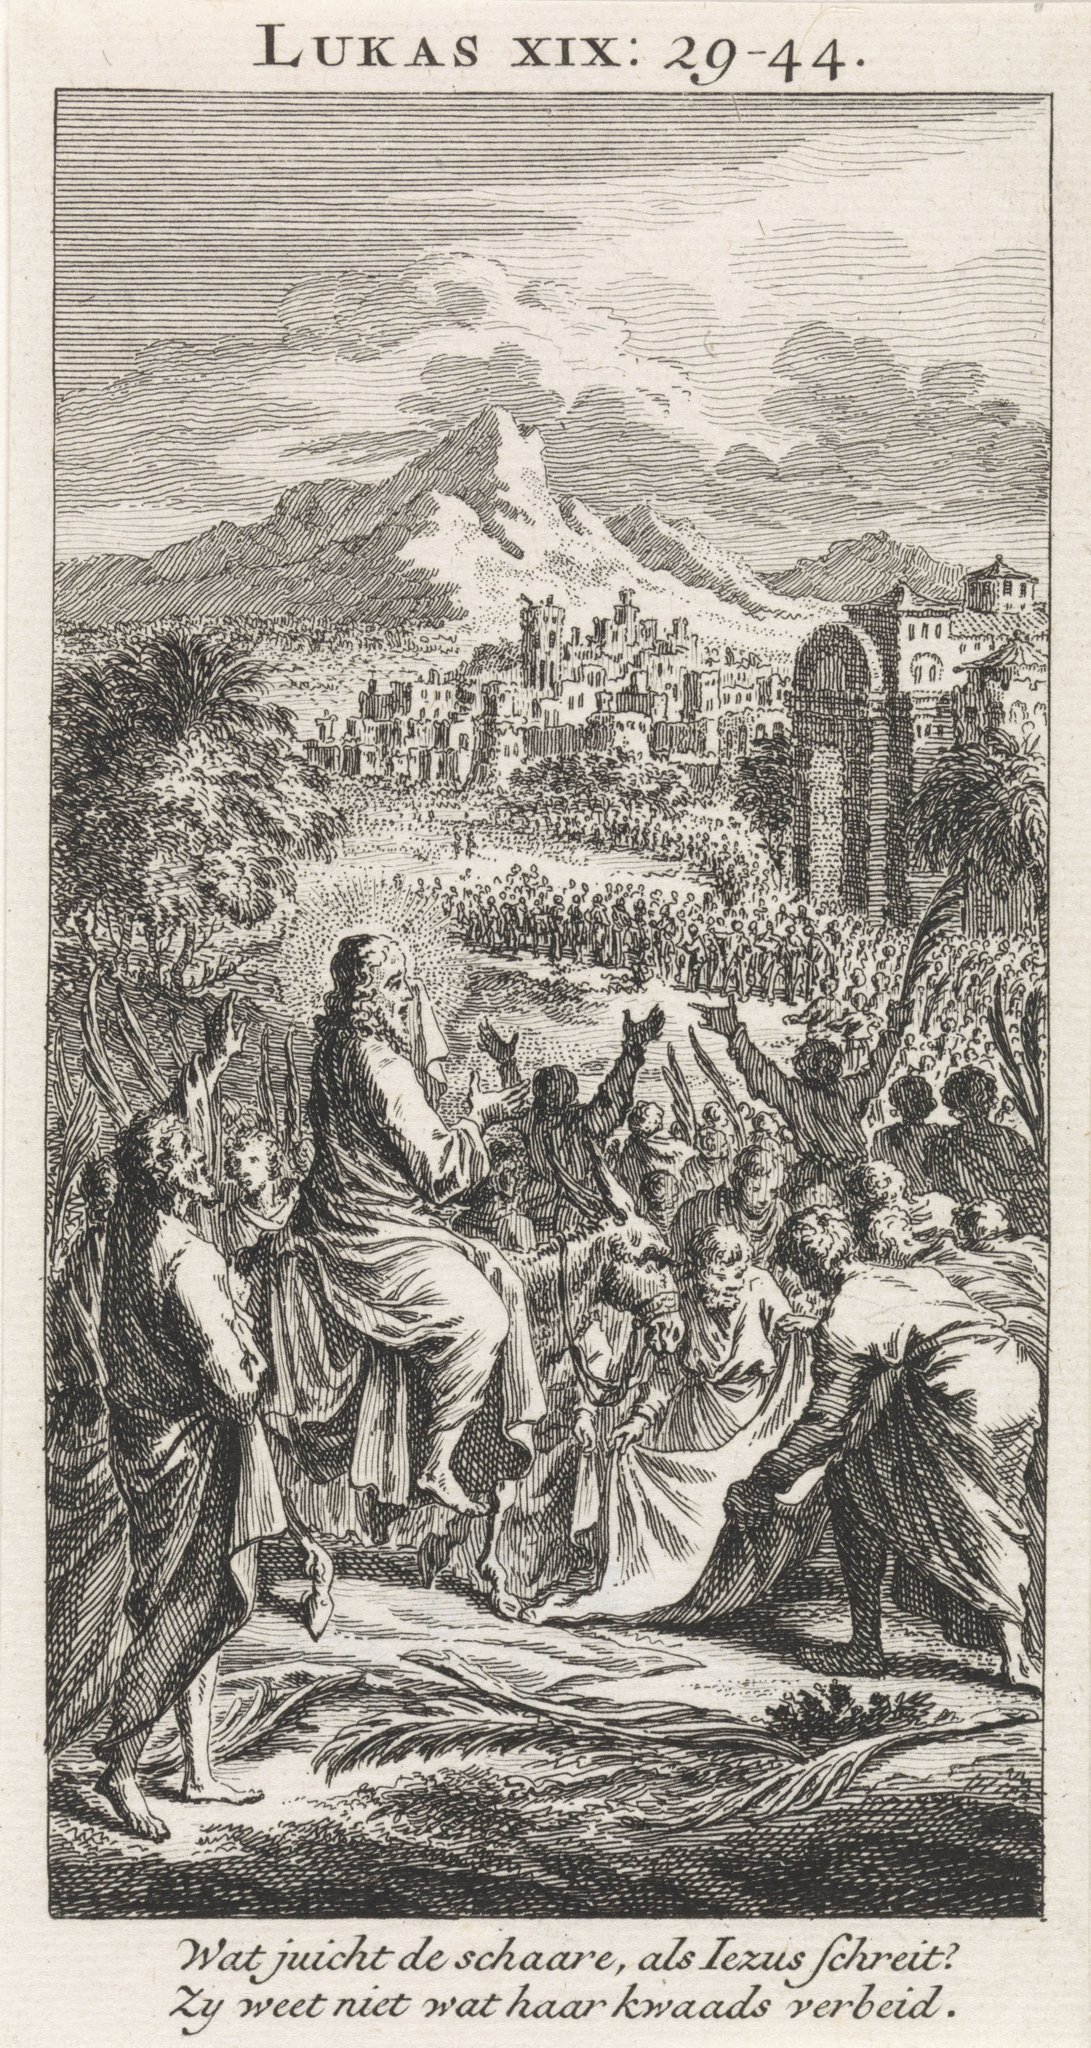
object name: print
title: Intocht in Jerusalem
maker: Anonymous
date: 1712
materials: paper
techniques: etching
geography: amsterdam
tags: entry into jerusalem: people spreading their clothes before christ on the ass, and waving palm branches (matthew 21:1-11, 21:14-16; mark 11:1-11; luke 19:28-40; john 12:12-19)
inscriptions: collector's mark: Lugt 2228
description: Kopie van illustratie voor: Luyken, Jan. Bybel printen. Amsterdam: Pieter Arentsz. II (wed.) en Cornelis van der Sys, 1712, p. 30.